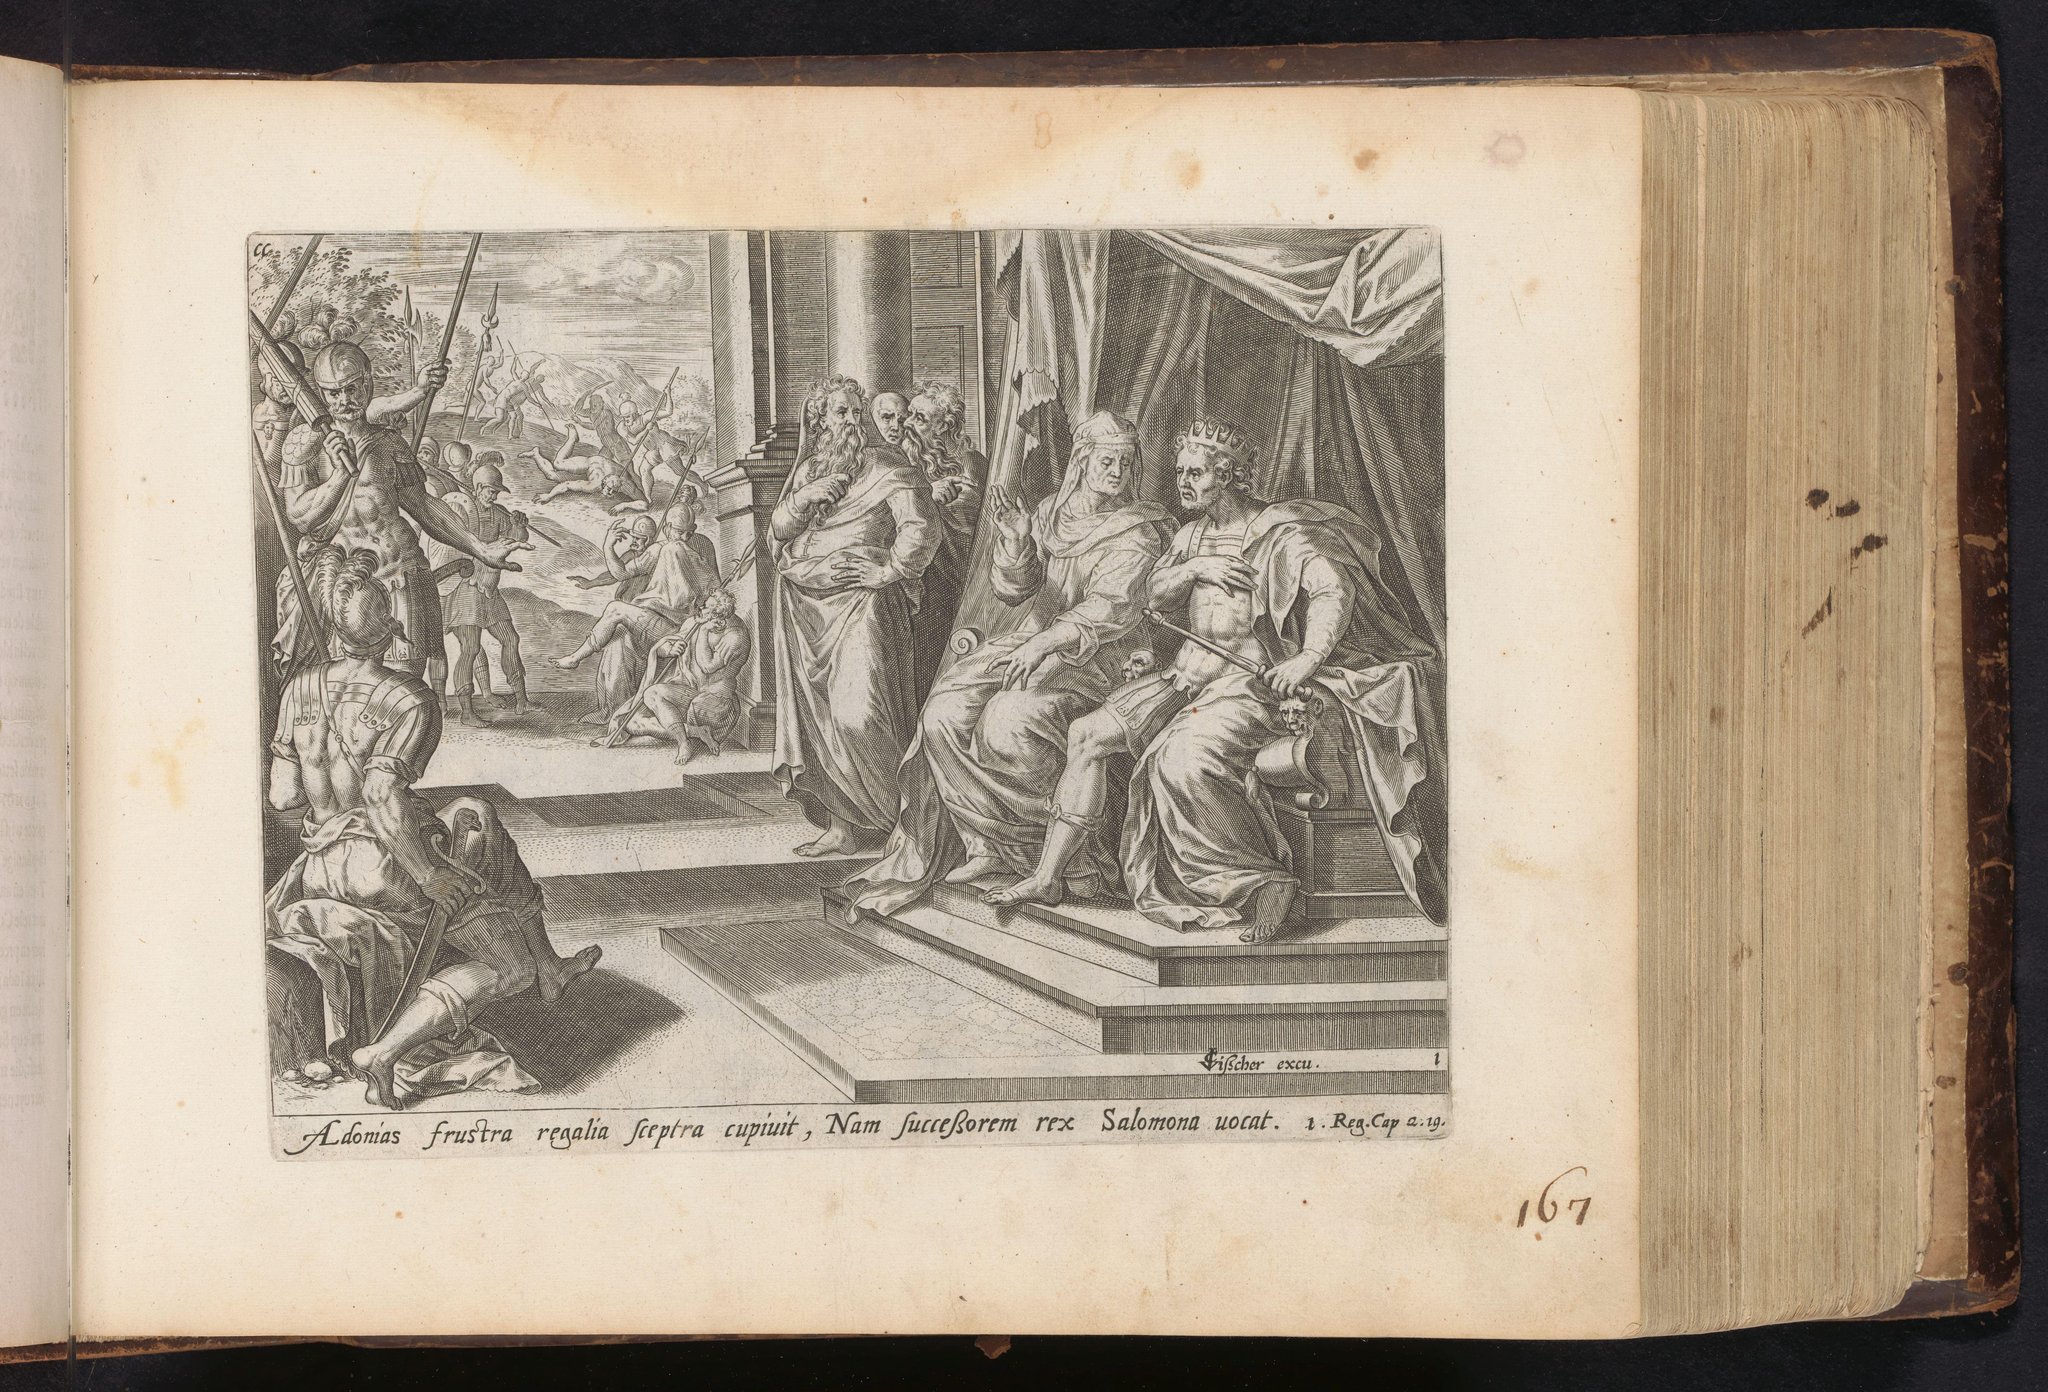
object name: print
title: Den Grooten Figuer-Bibel (...)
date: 1579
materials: paper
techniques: engraving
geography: amsterdam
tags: bathsheba brings adoniah's request to solomon, adoniah is killed by benaiah, solomon and bathsheba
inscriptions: number: ‘167’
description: Batseba zit aan de rechterhand van haar zoon, koning Salomo, en brengt de vraag van Salomo's broer Adonia aan hem over. Zij vraagt voor Adonia om de hand van Abisag. Salomo wordt woedend en geeft opdracht Adonia te doden. Op de achtergrond wordt Adonia met een lans doorstoken. Onder de voorstelling een verwijzing in het Latijn naar de Bijbeltekst in 1 Kon. 2:19. Deze prent maakt deel uit van een album.